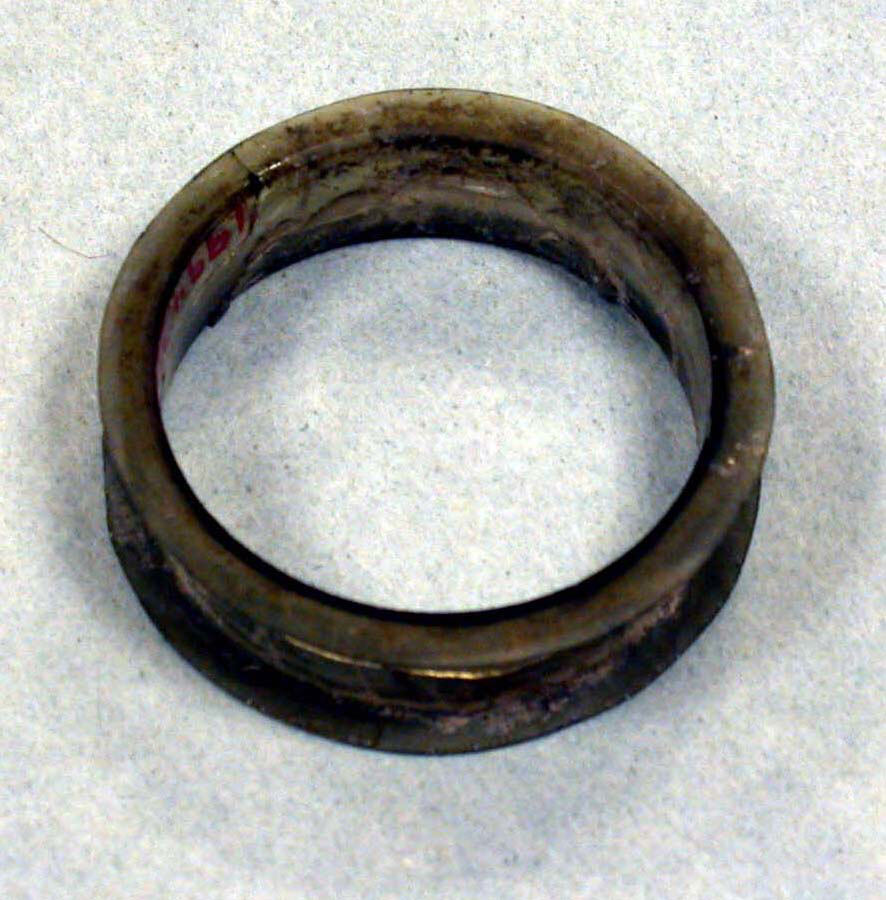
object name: ear spool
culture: mexican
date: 1501-1600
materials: obsidian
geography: mexico